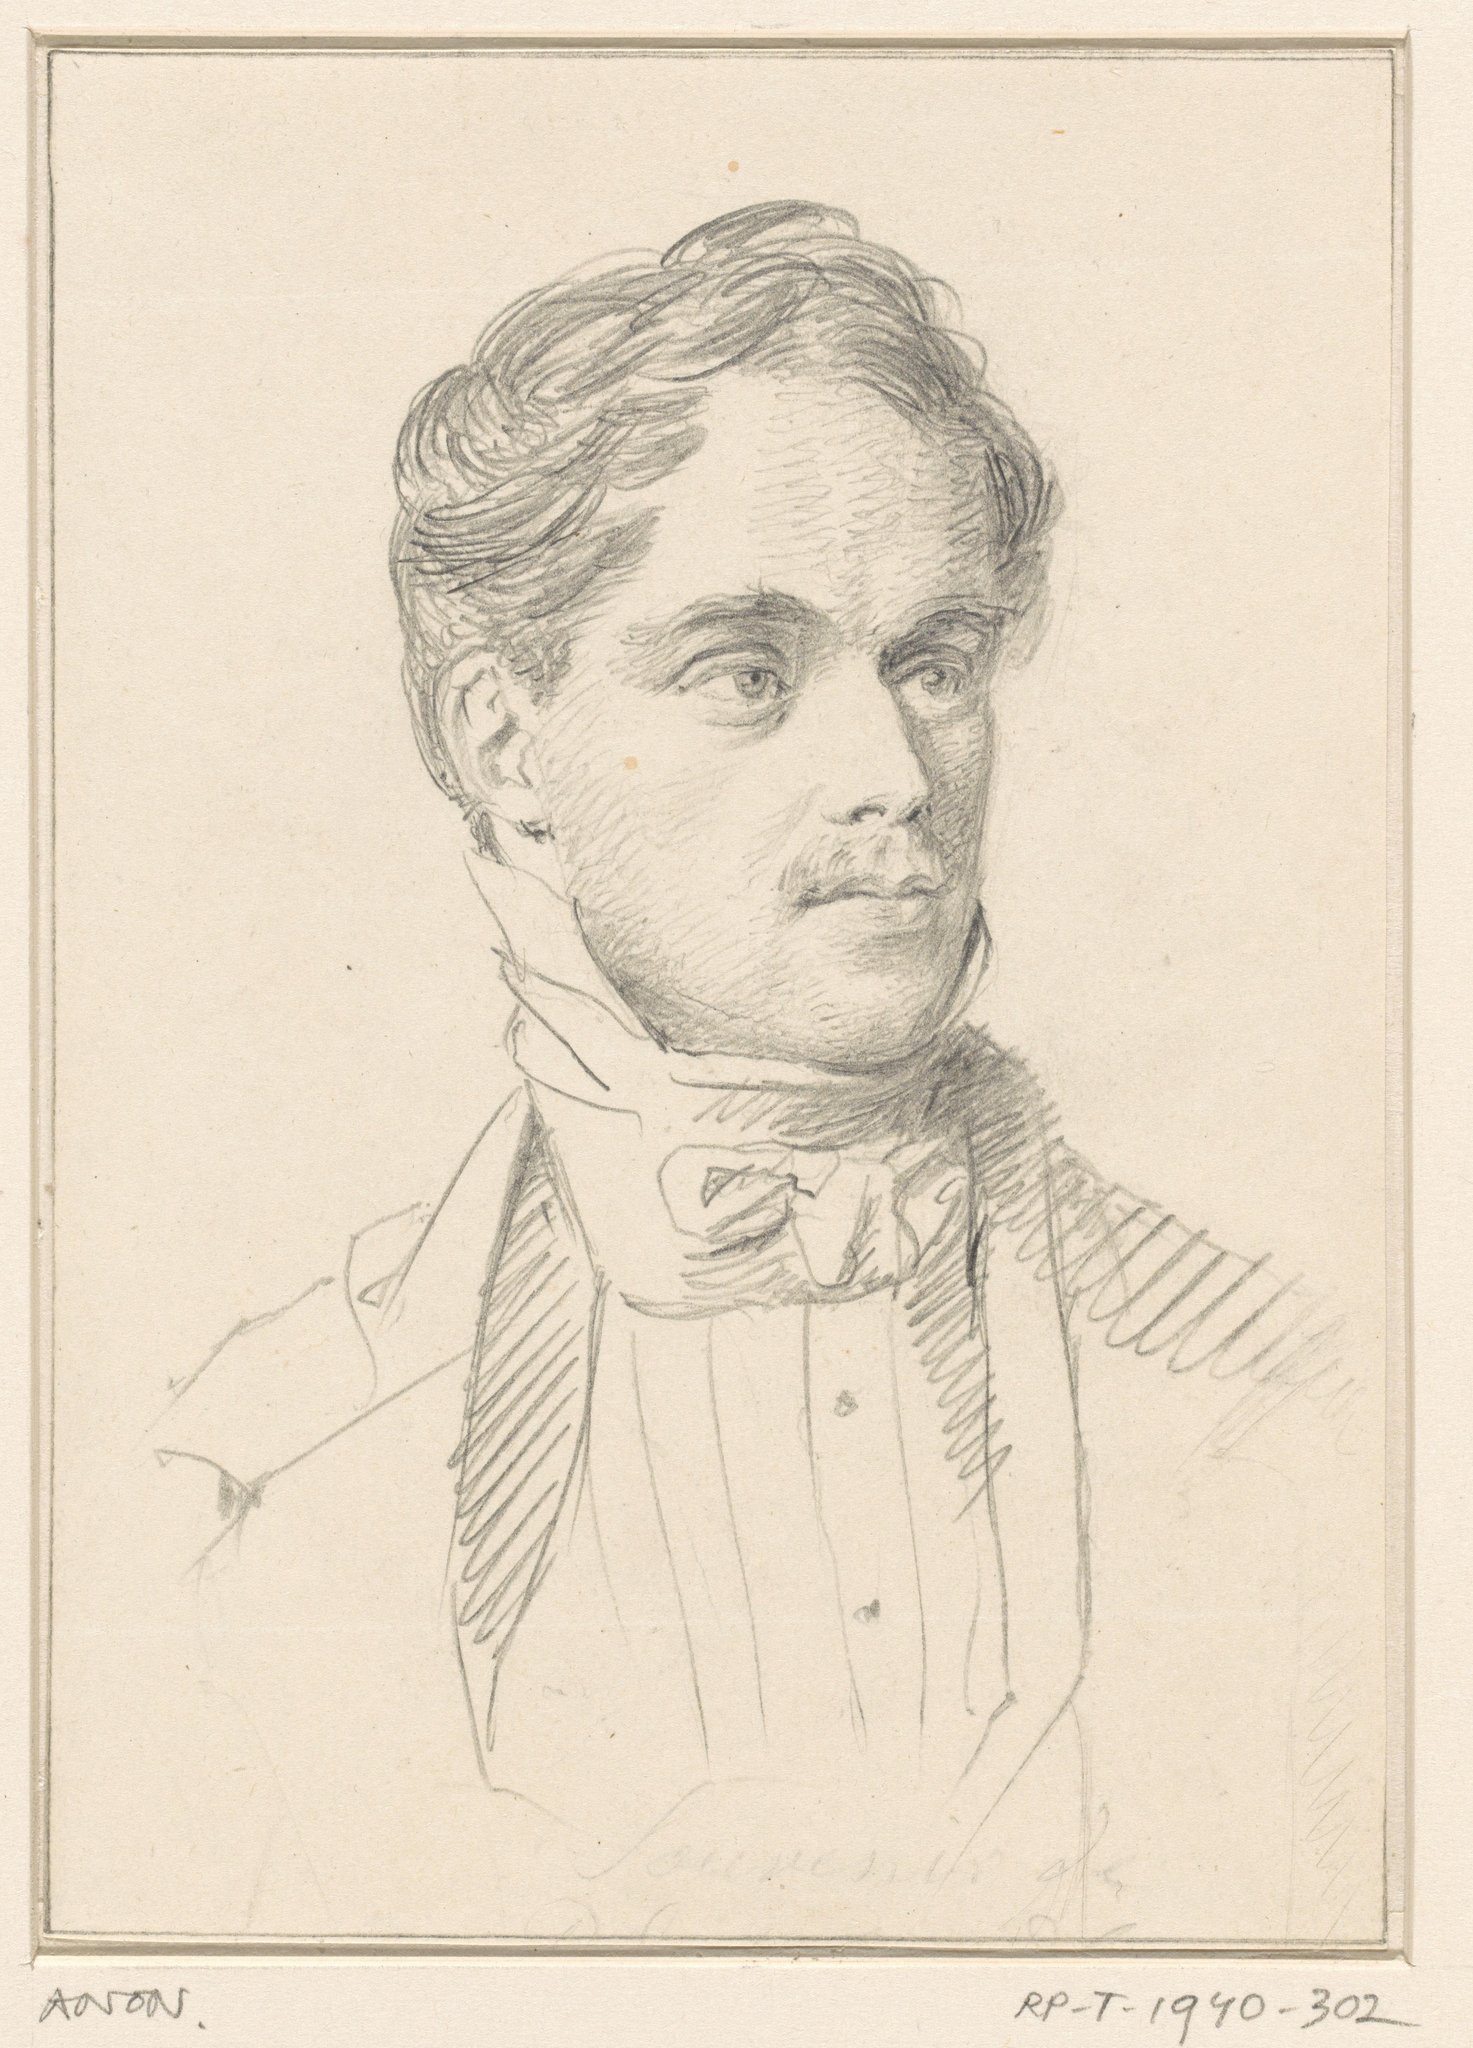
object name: drawing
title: Portret van Michel Ghislain Stapleaux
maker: Anonymous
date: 1800-1881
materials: paper, pencil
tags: brussels, painter, michel ghislain stapleaux, historical persons, portrait, self-portrait of artist